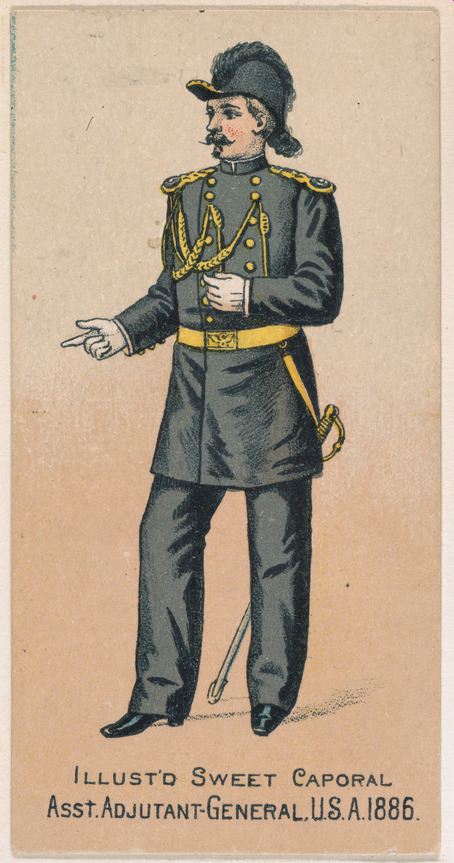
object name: print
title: Assistant Adjutant-General, United States Army, 1886, from the Military Series (N224) issued by Kinney Tobacco Company to promote Sweet Caporal Cigarettes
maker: kinney brothers tobacco company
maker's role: publisher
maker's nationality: american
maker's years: 1869-2011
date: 1888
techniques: color lithograph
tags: men,profiles,generals